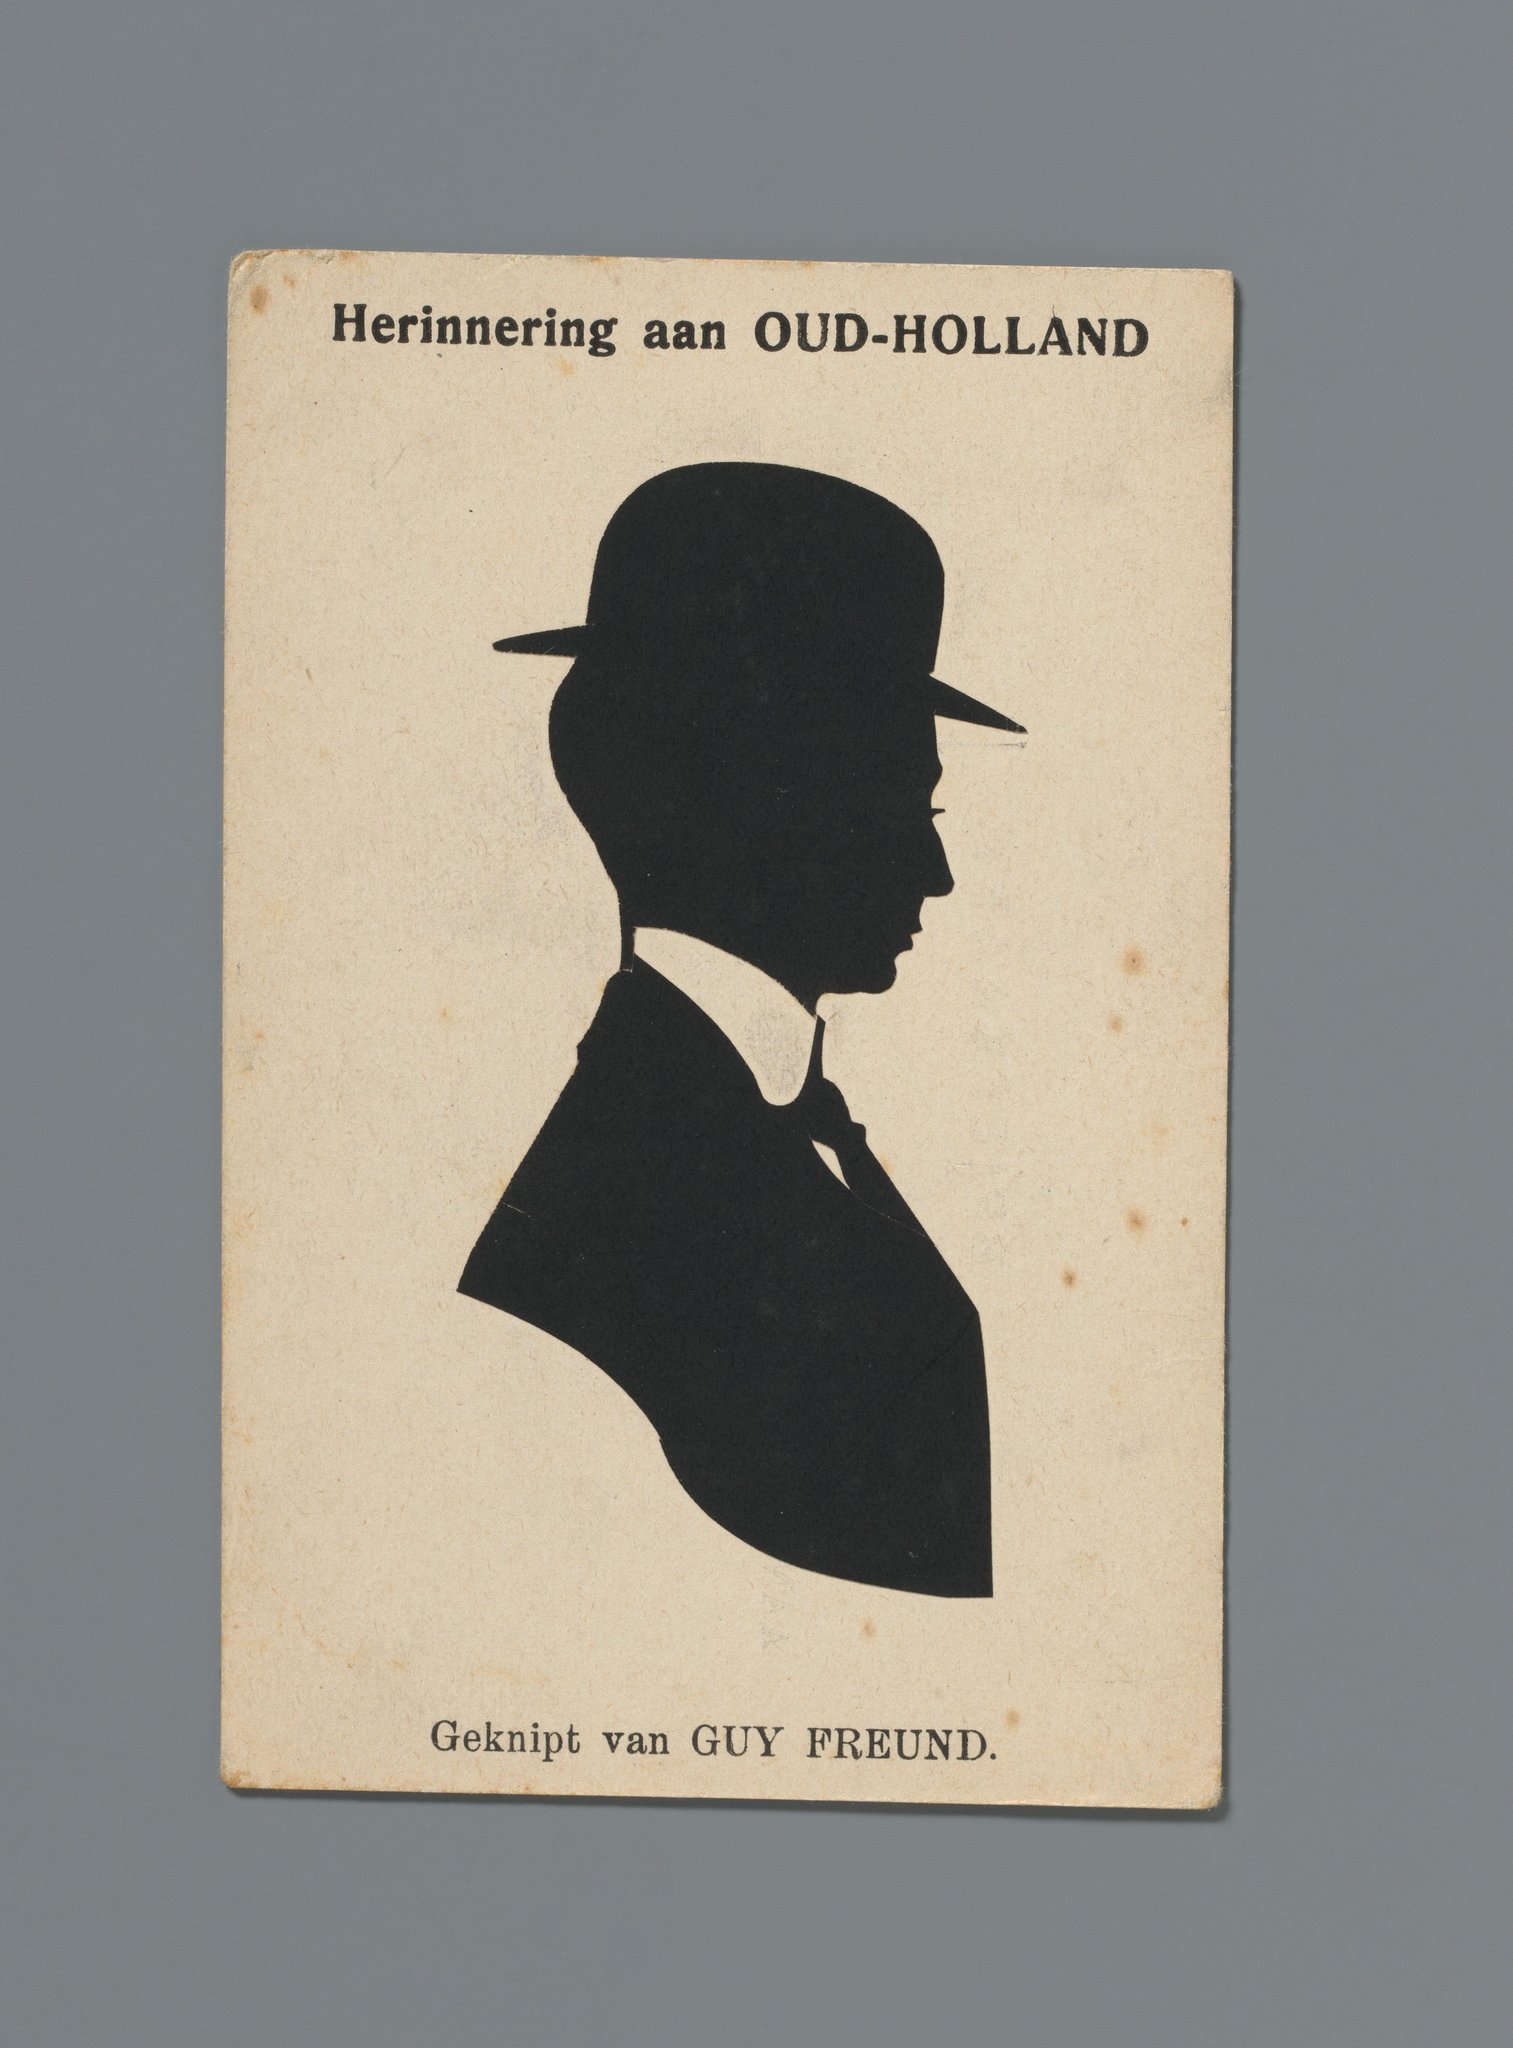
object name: ansichtkaart, prentbriefkaart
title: Herinnering aan Oud-Holland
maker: Anonymous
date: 1890-1905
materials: cardboard, paper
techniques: snipping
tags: adult man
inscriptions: inscription: ‘Geknipt van GUY FREUND.’